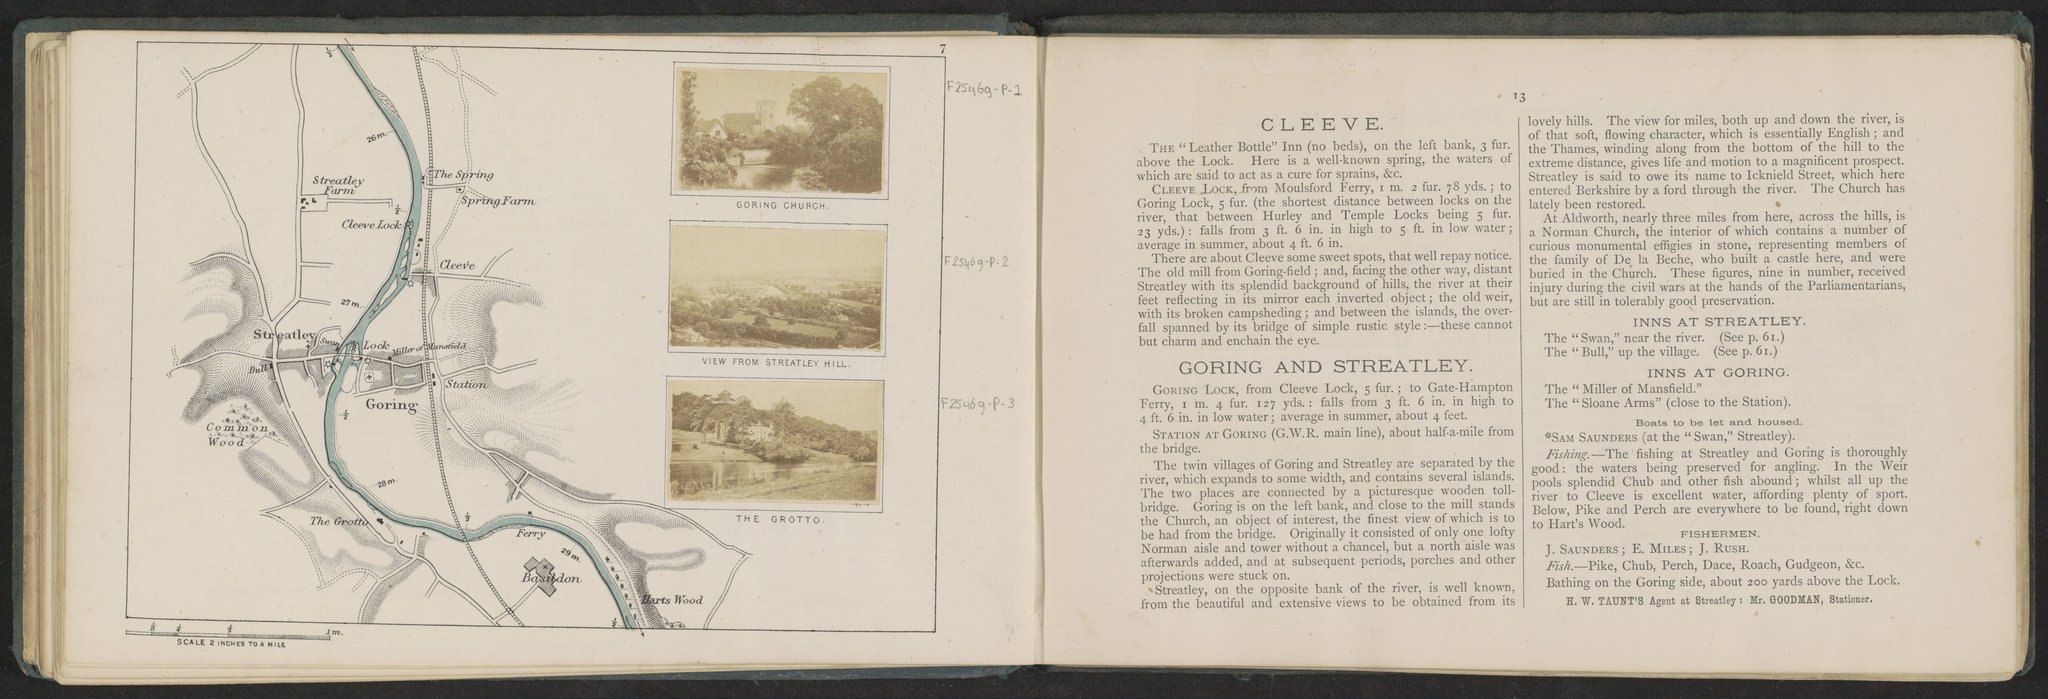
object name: page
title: Gezicht op een folly in een park bij Goring-on-Thames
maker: henry w. taunt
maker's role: fotograaf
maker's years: 1842-1922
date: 1871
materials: photographic support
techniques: albumen print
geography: goring-on-thames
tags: architectural folly, river, thames